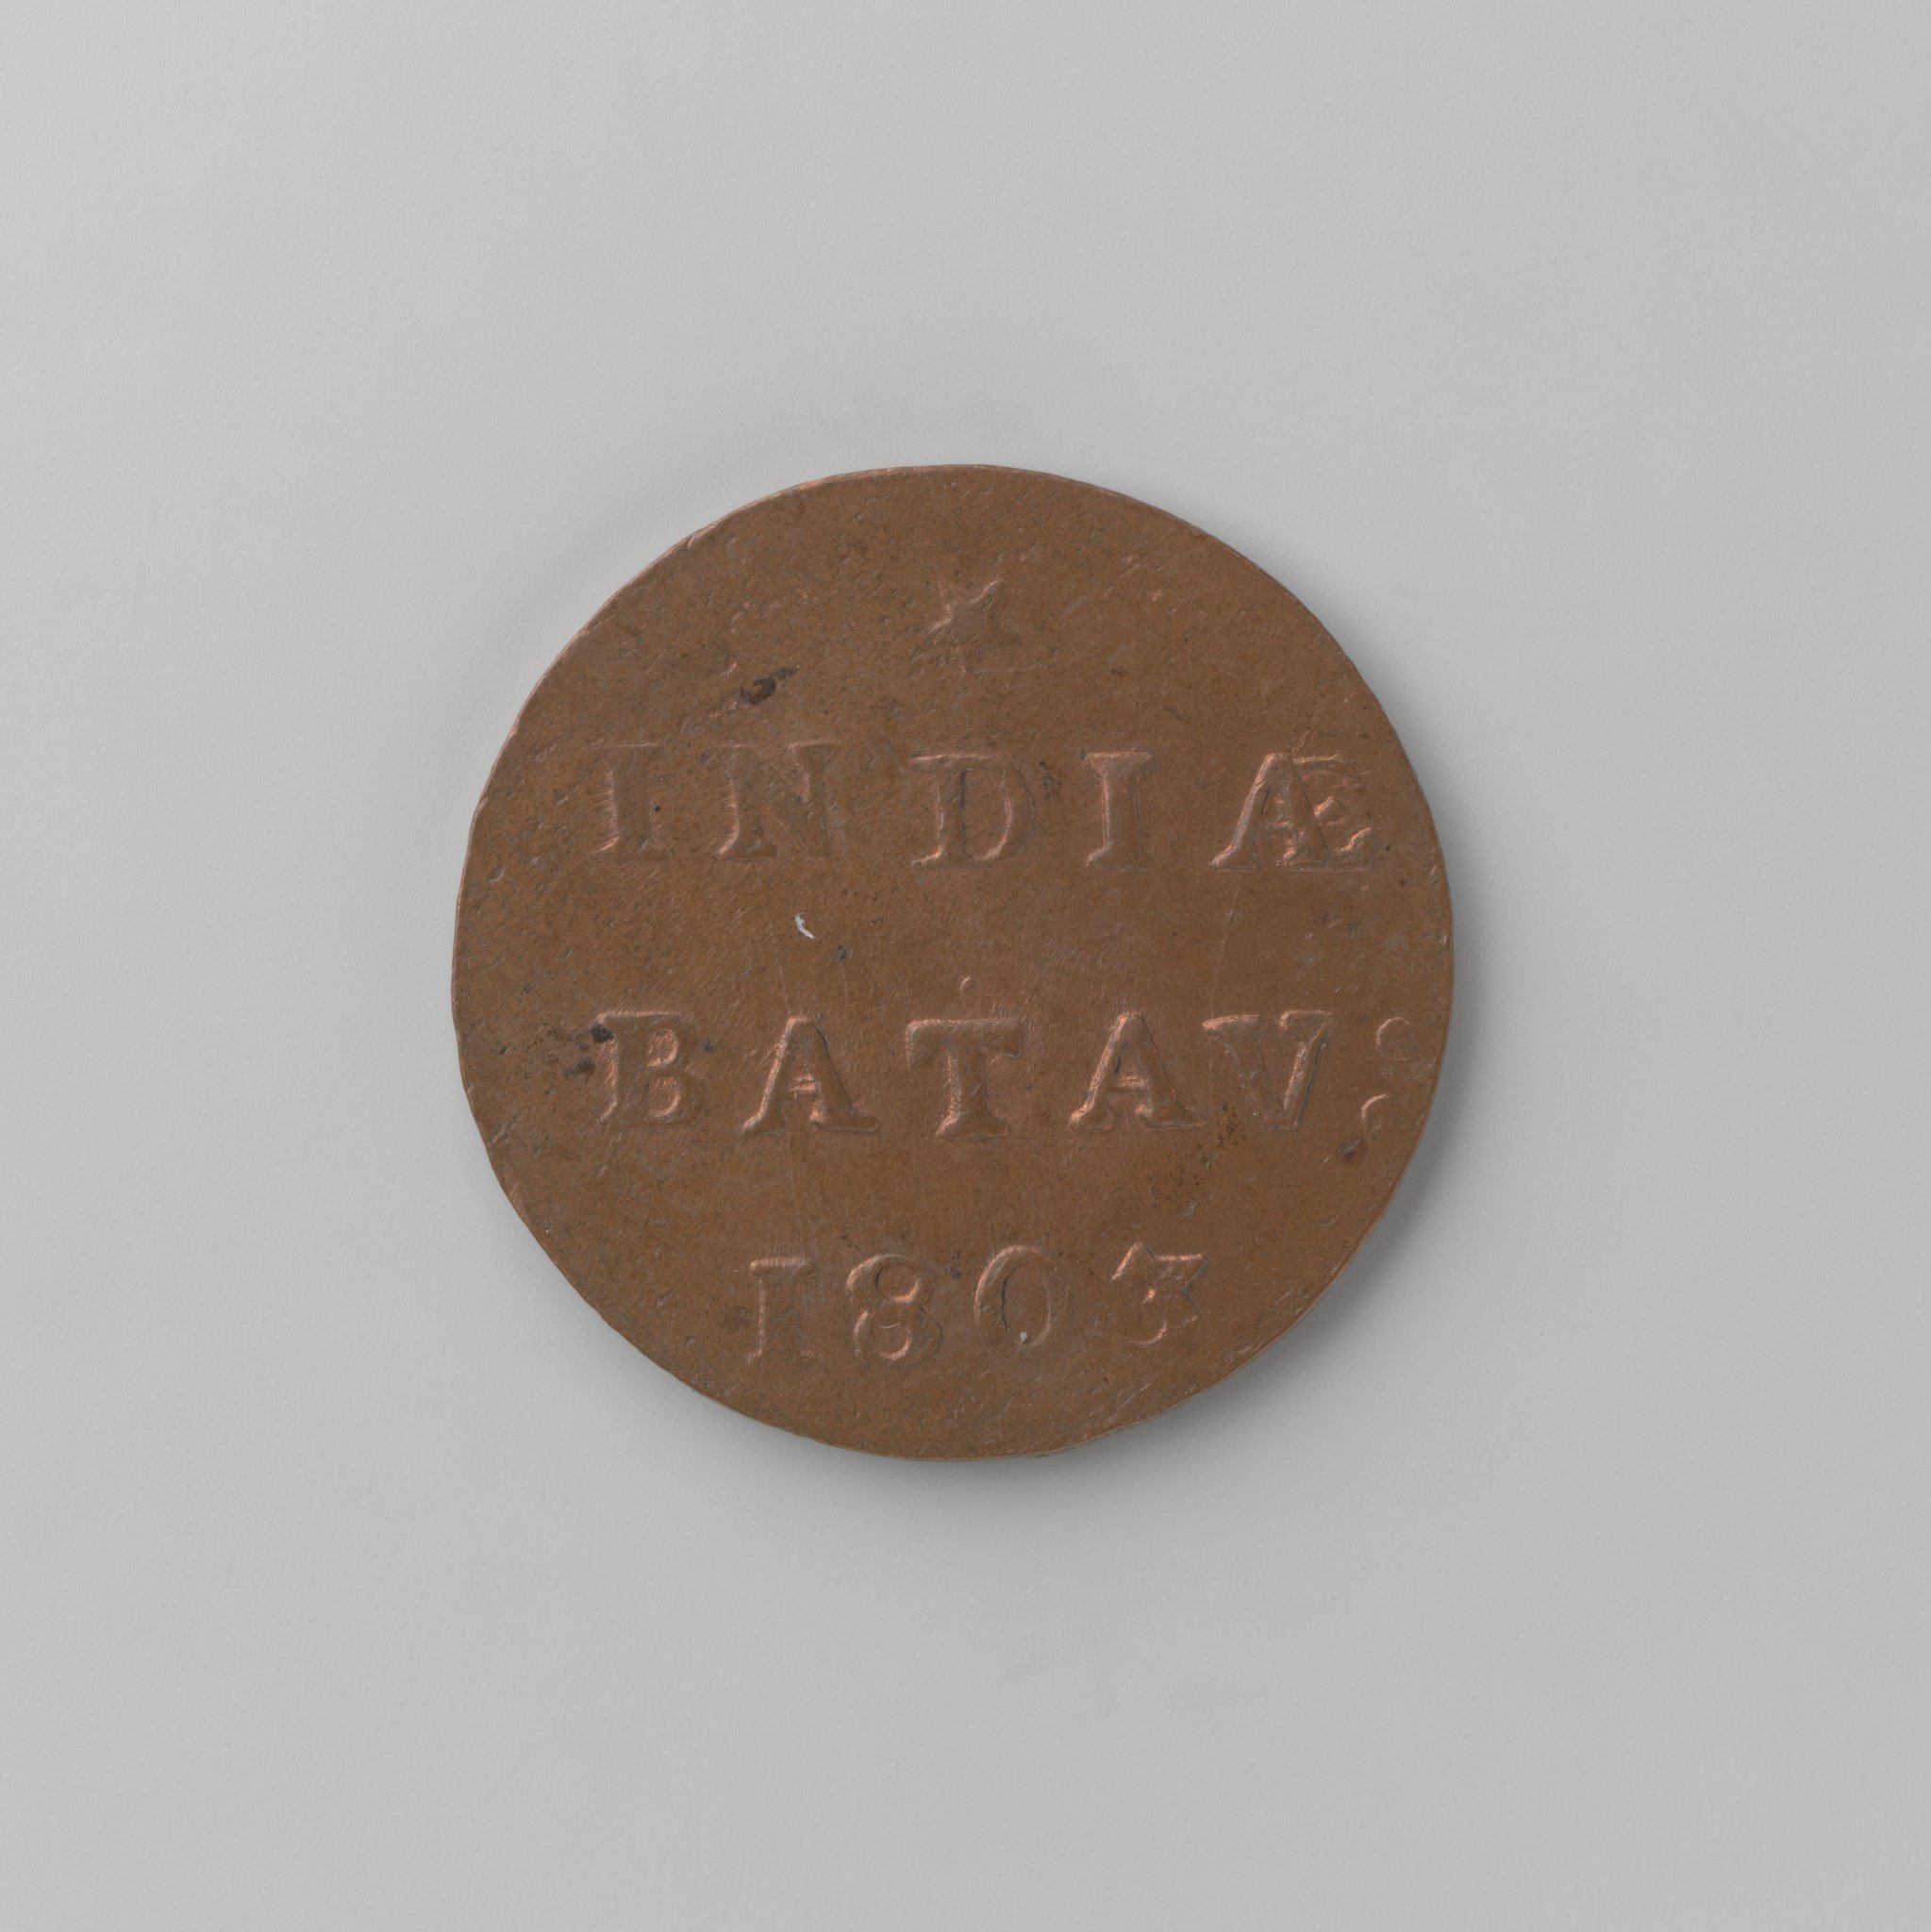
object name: coin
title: Nederlands Indië, duit Holland,1803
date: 1803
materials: copper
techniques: striking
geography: enkhuizen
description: Koperen munt. Voorzijde: tweeregelig opschrift, waarboven muntteken ster en waaronder jaartal. Keerzijde: tussen waarde-aanduiding 5 1/16 G gekroond generaliteitswapenschild. Gladde rand.